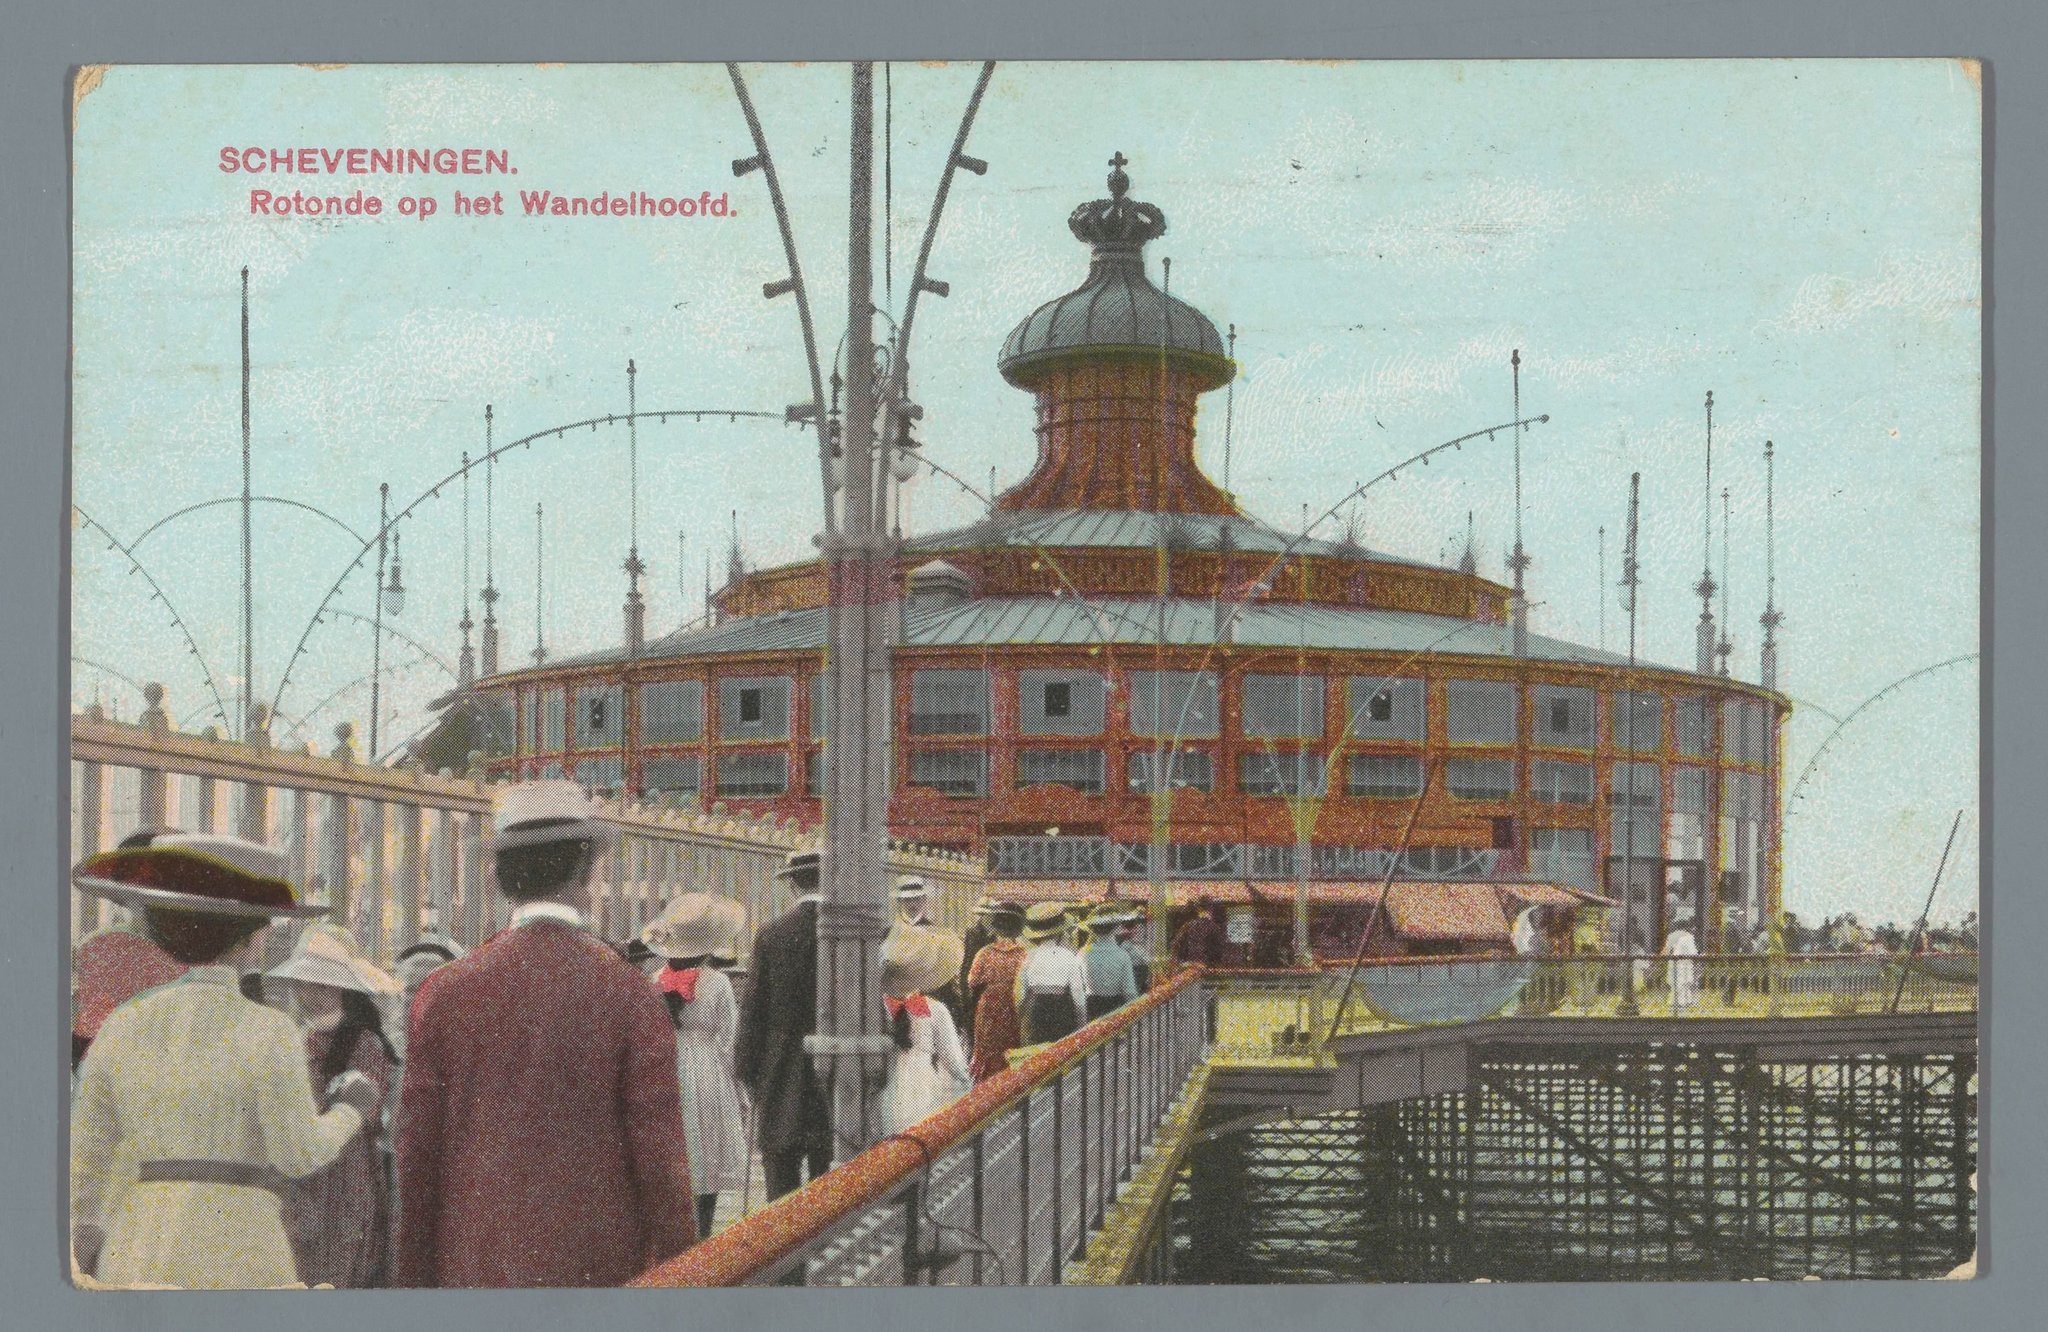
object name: ansichtkaart, prentbriefkaart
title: Scheveningen, Rotonde op het Wandelhoofd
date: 1912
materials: cardboard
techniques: writing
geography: the hague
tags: pier, quay, wharf